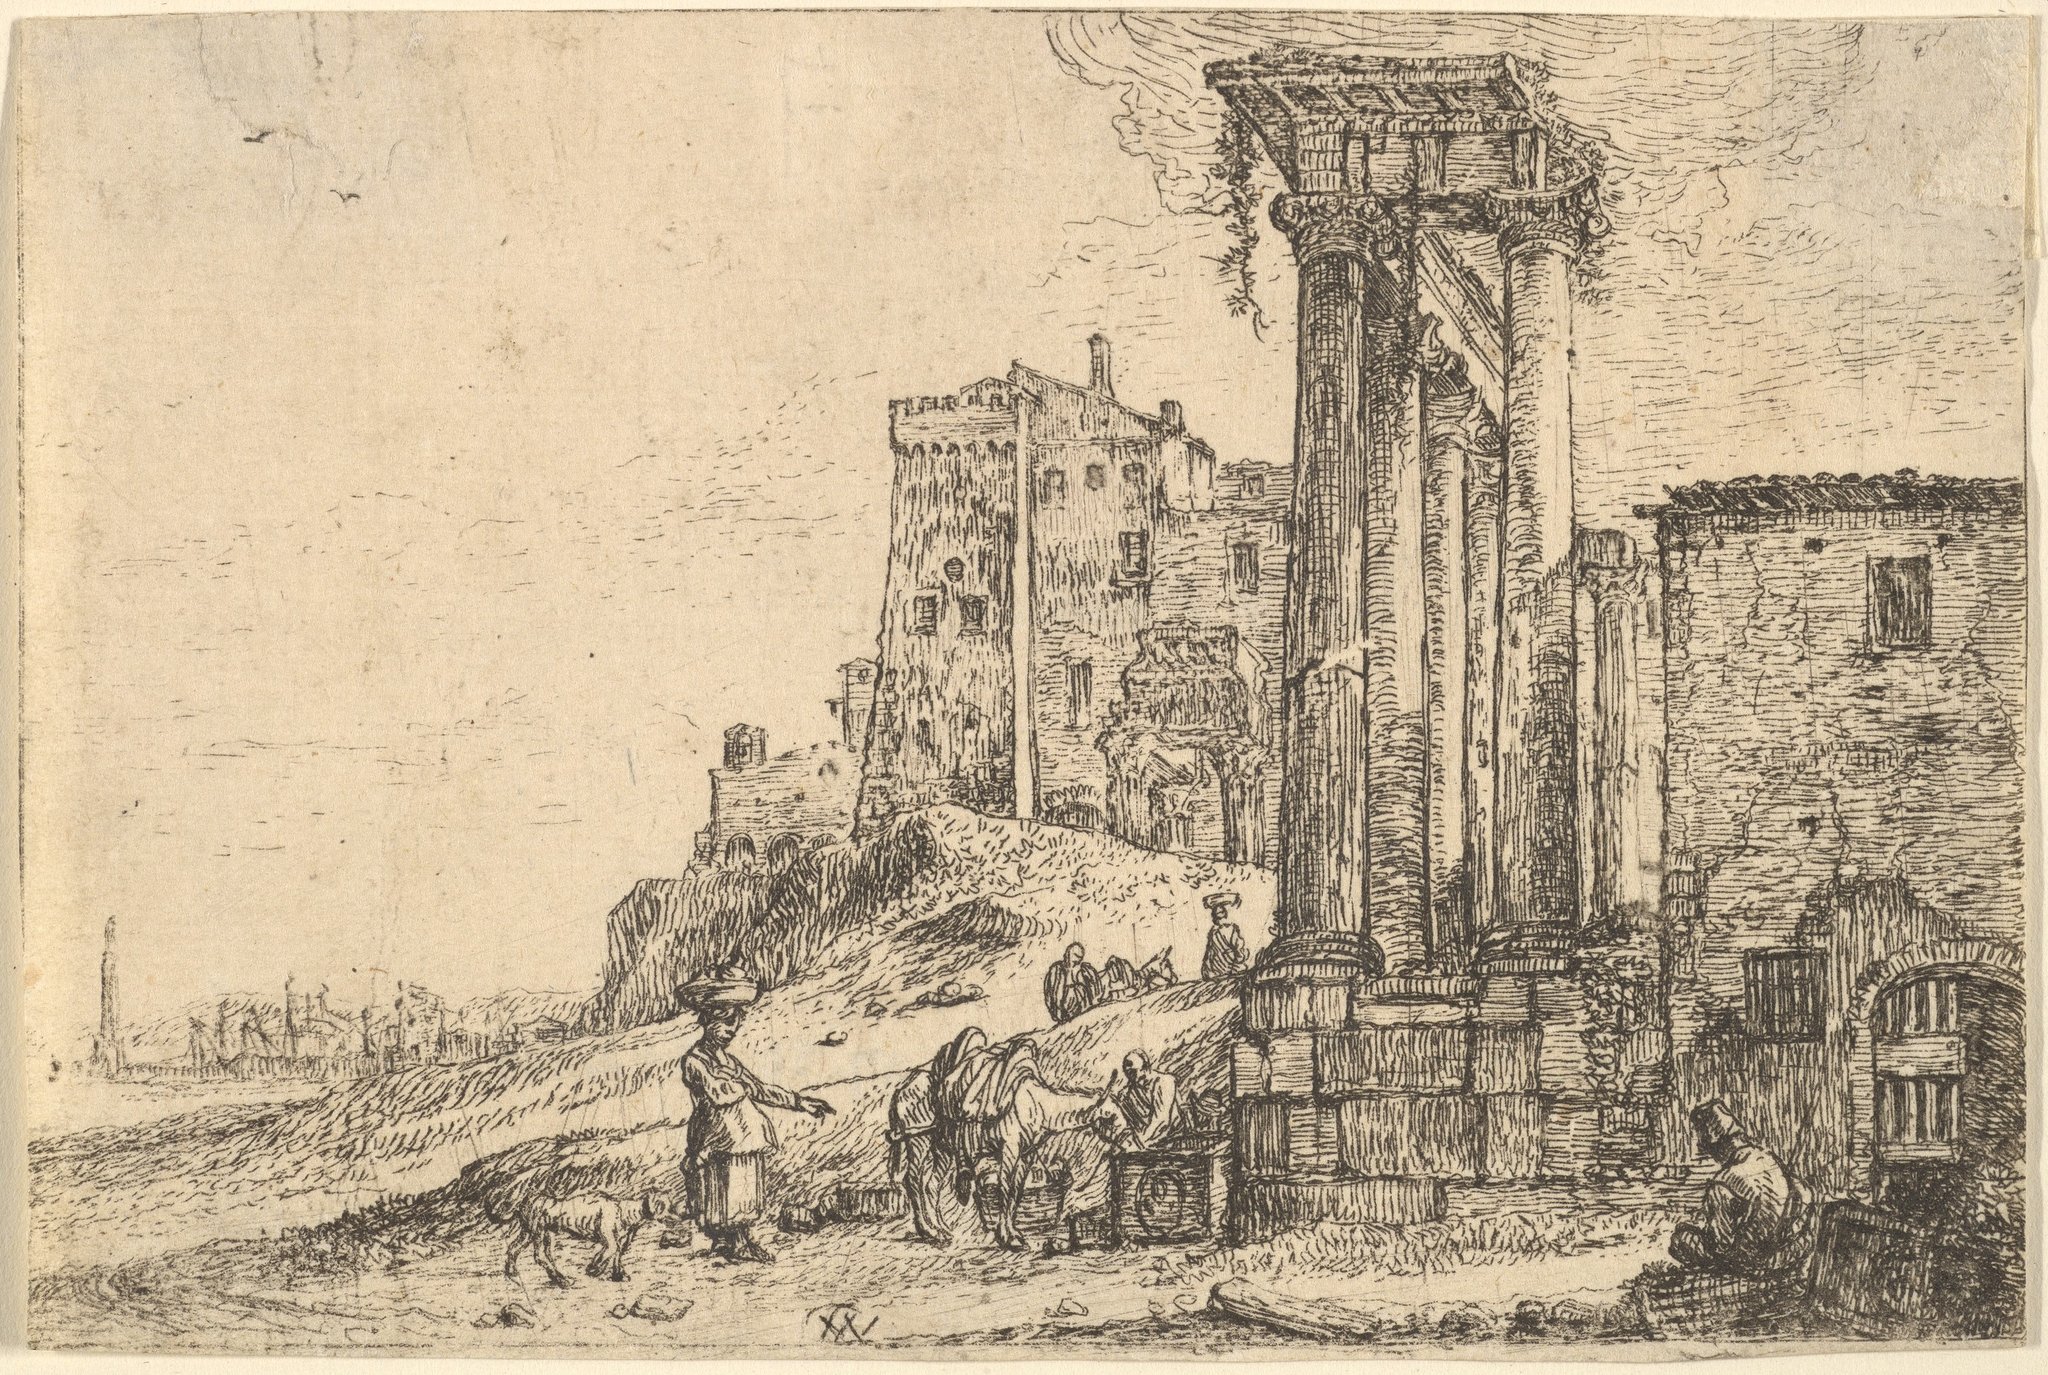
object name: print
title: The Collonade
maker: thomas wijck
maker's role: artist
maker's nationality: dutch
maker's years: 1616-1677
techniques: etching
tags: columns,men,horses